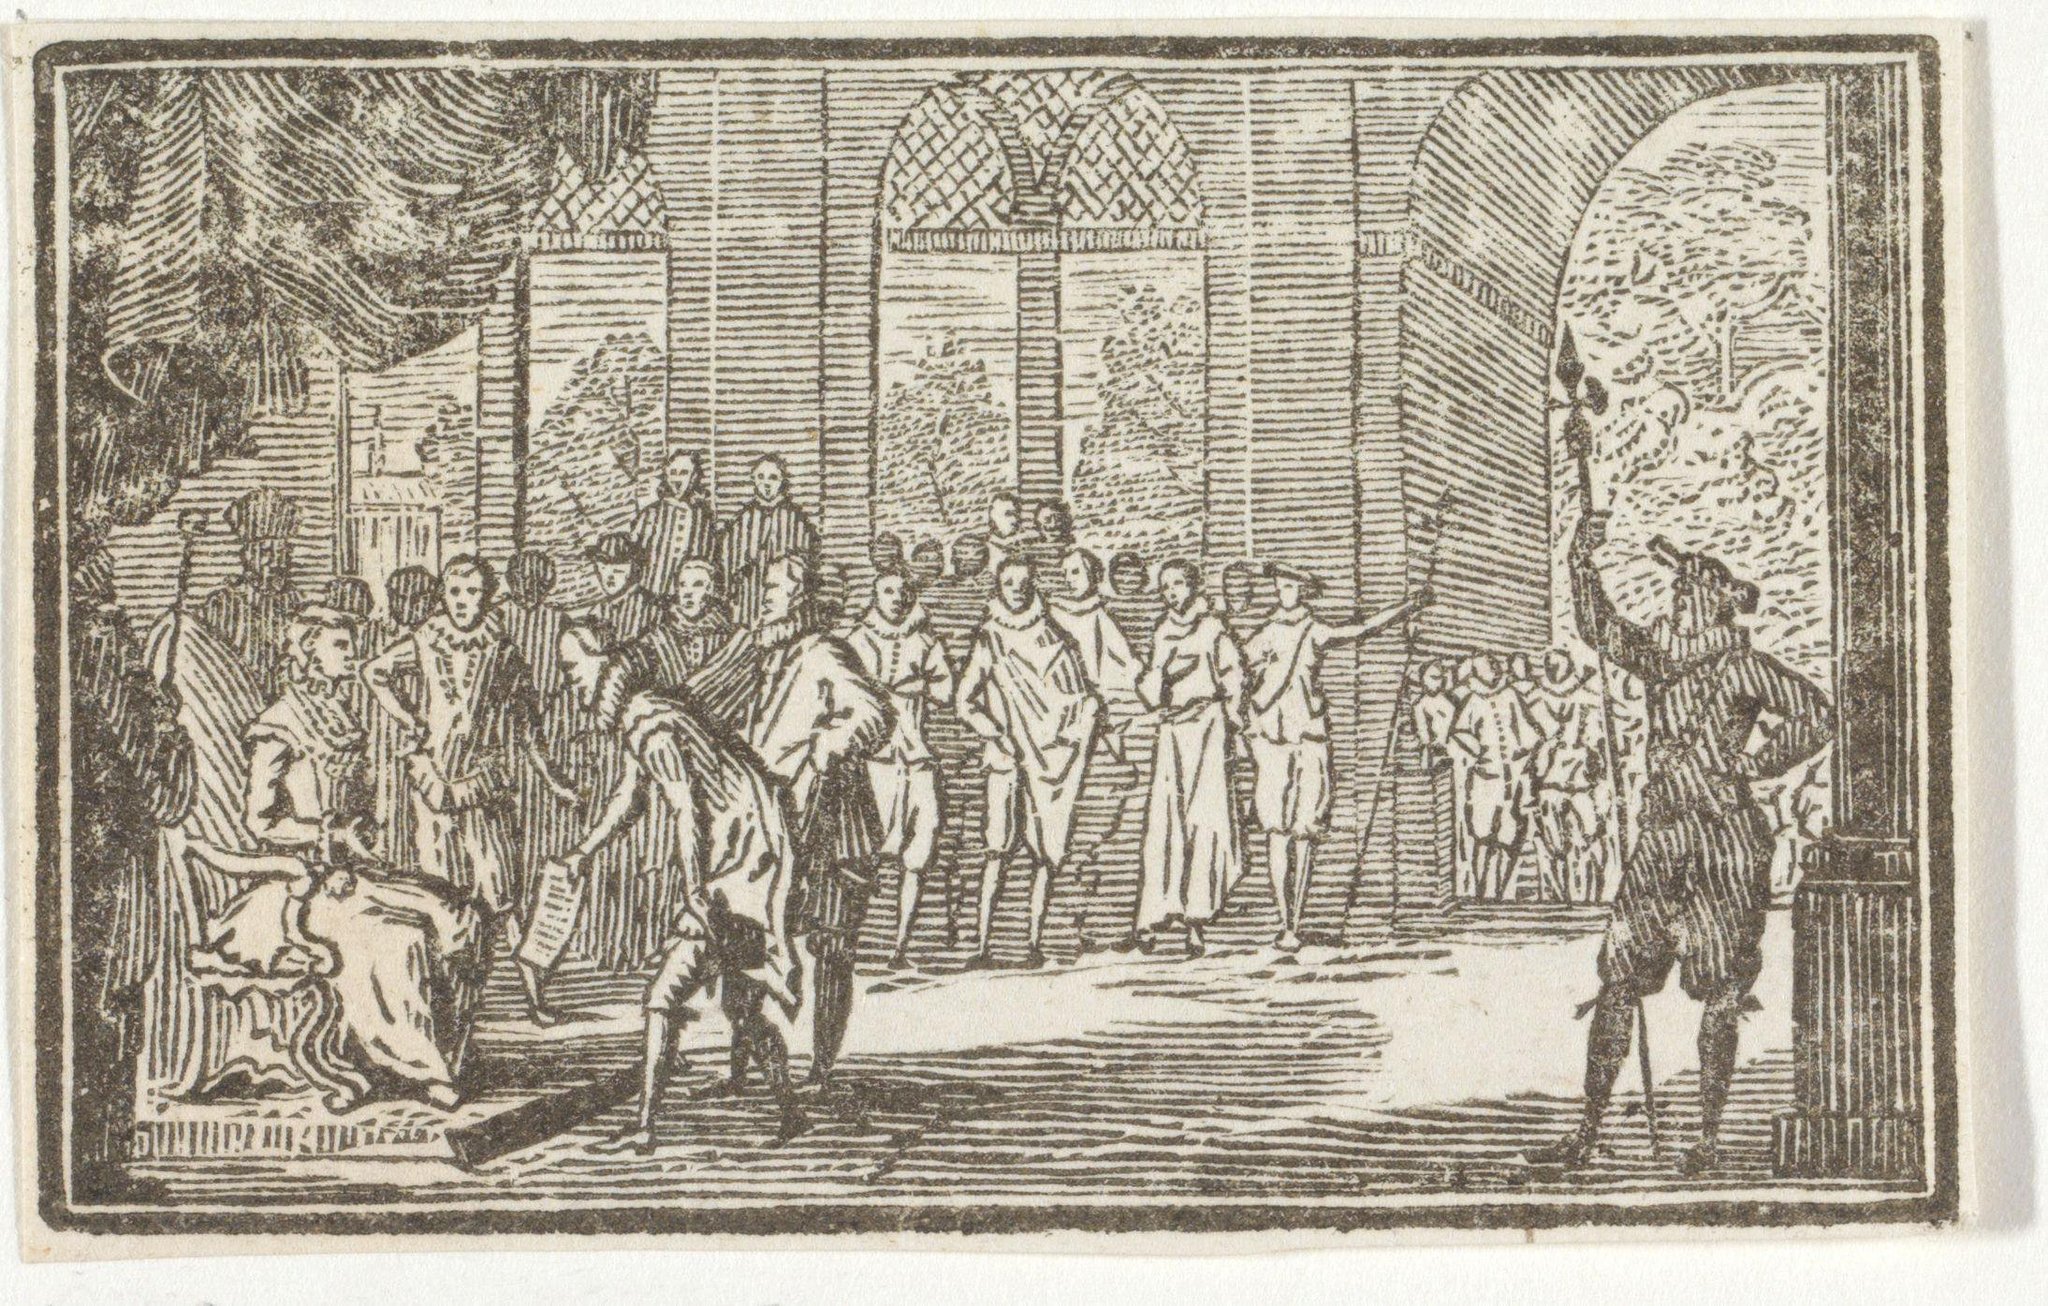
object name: print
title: Man met een kraag biedt een vrouw op een troon een document aan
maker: cornelis van noorde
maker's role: draughtsman, print maker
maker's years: 1731-1795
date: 1741-1795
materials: paper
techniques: woodcut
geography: haarlem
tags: throne, handwriting, written text, neck-gear: collar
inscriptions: collector's mark: Lugt 240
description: In een grote zaal staan meerdere figuren en een aantal gewapende mannen. Zij kijken toe hoe een vrouw op een troon een document krijgt aangeboden van een man met een kraag.